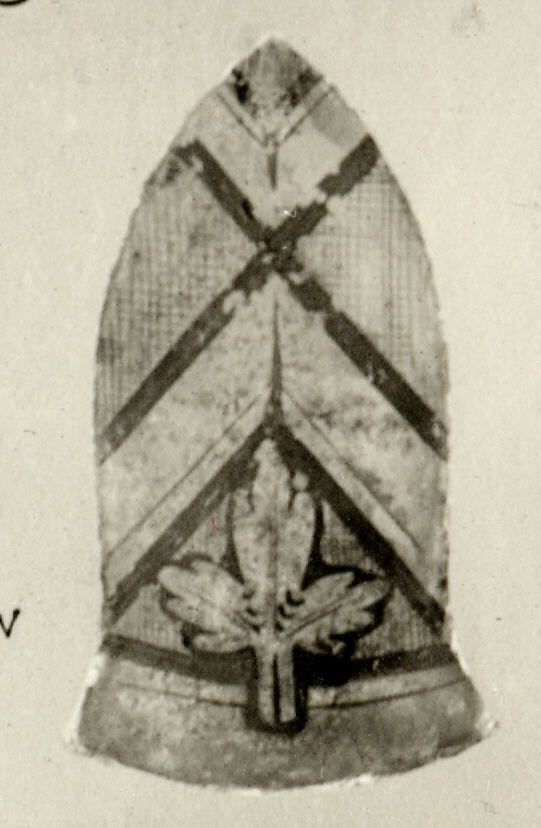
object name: fragment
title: Glass Fragment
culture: french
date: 1301-1400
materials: glass, paint